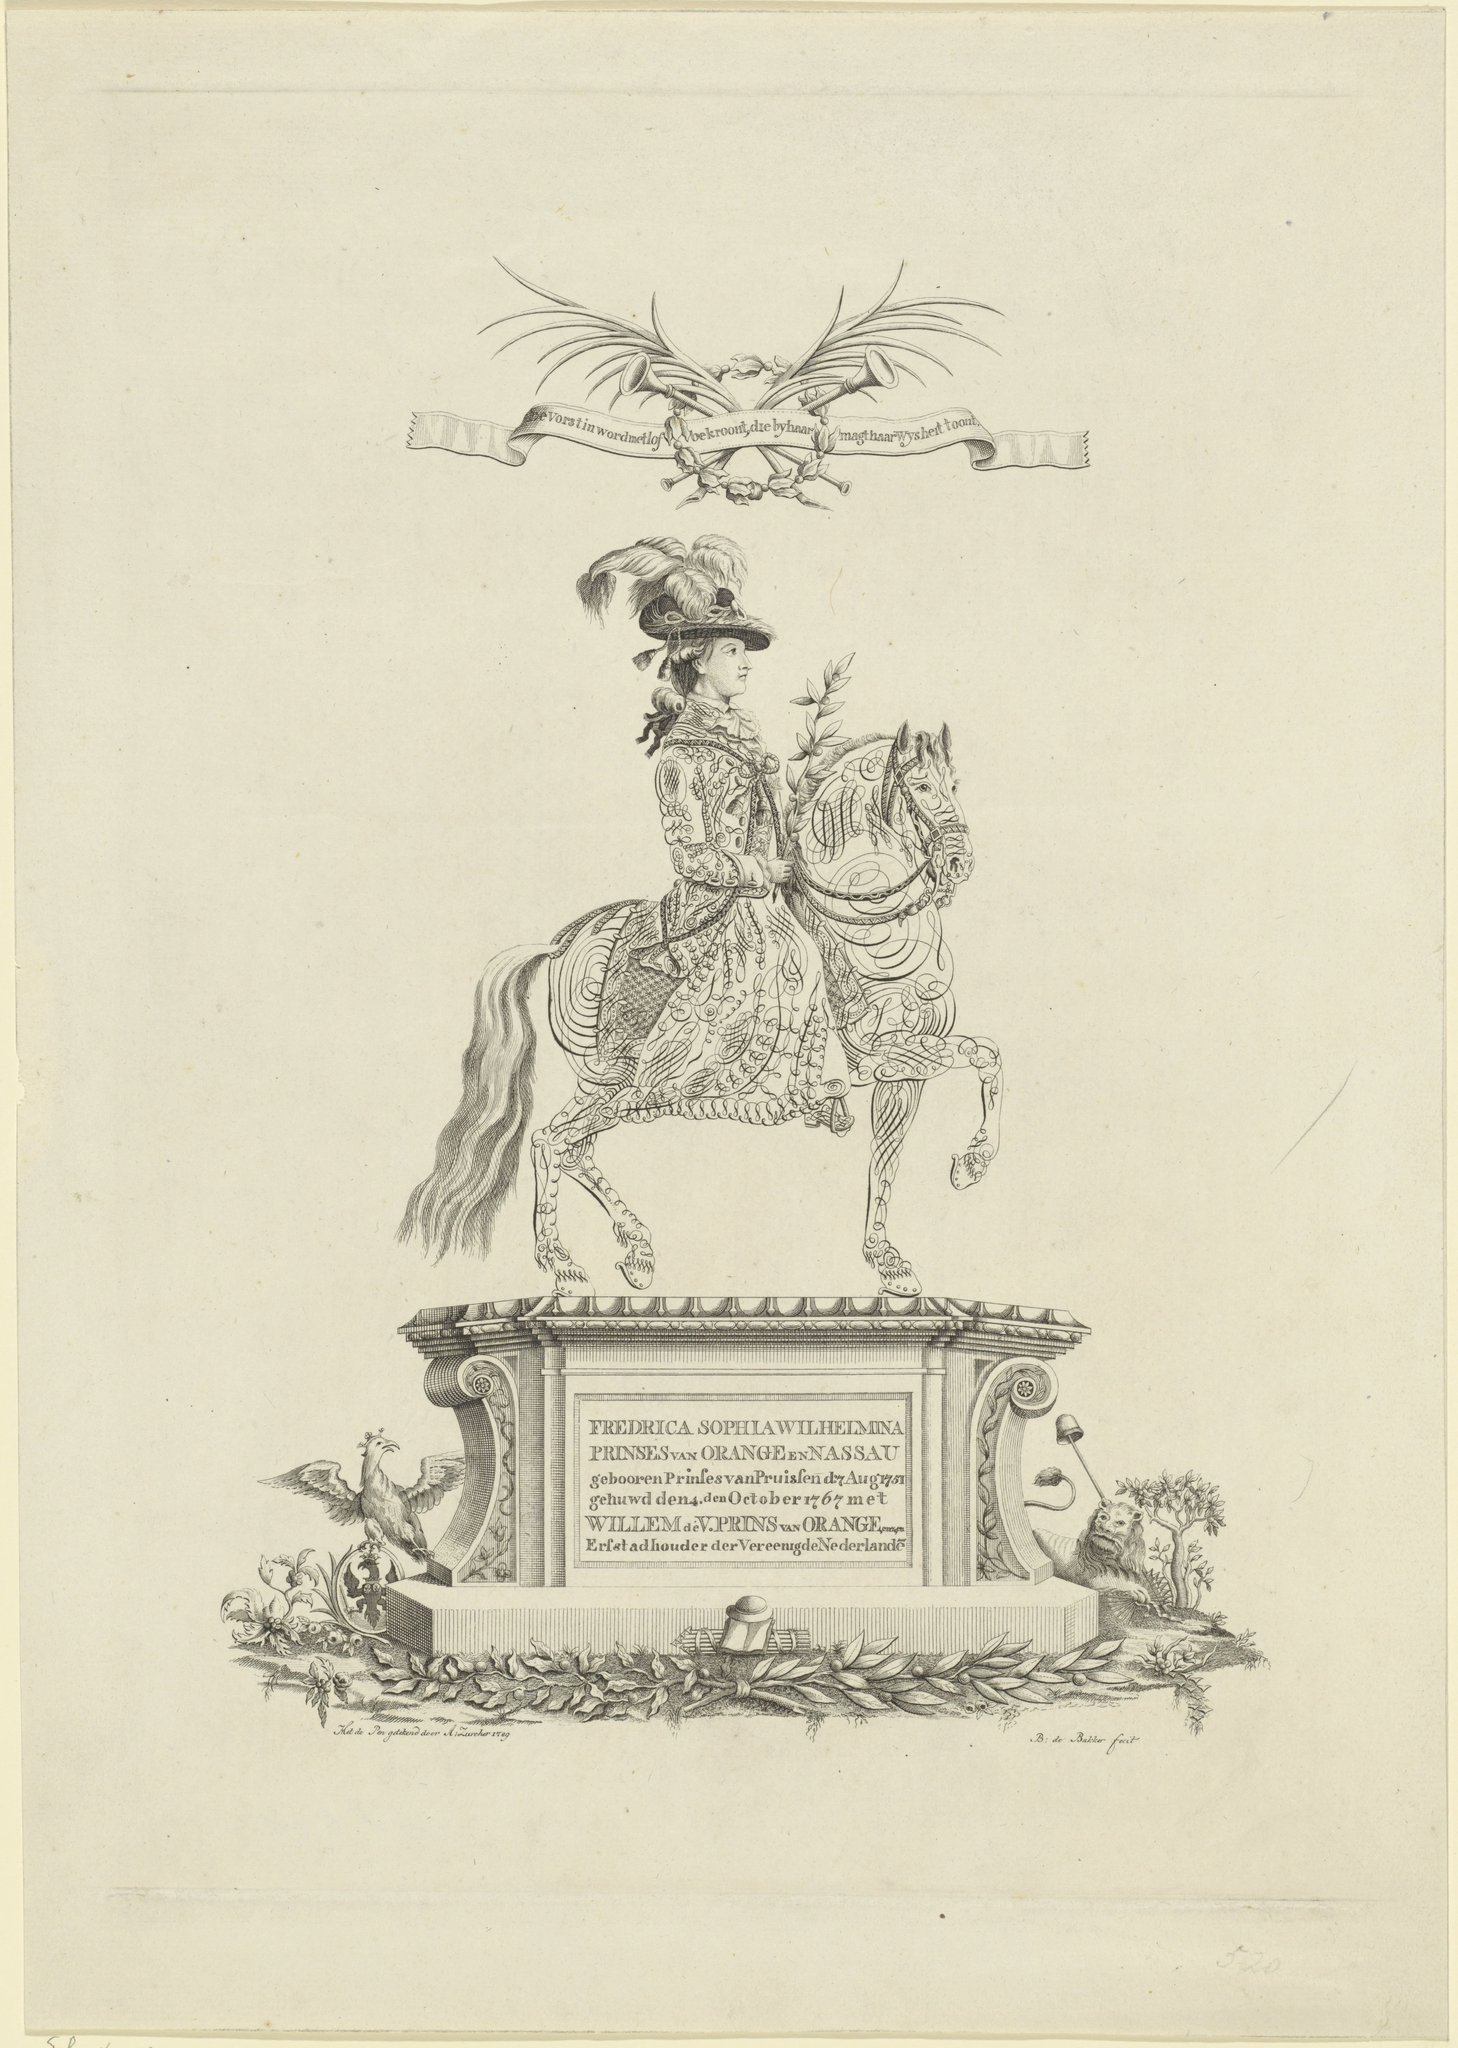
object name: print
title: Ruiterstandbeeld van Wilhelmina van Pruisen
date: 1789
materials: paper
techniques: engraving, etching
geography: amsterdam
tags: berlin, painter, draughtsman, wilhelmina of prussia (princess of orange), equestrian statue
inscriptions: date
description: Ruiterstandbeeld van Wilhelmina met een hoed. In haar rechterhand een oranjetak. Rondom liggen meerdere allegorische objecten. Op een banderol een regel Nederlandse tekst. Op een voetstuk zes regels Nederlandse tekst.